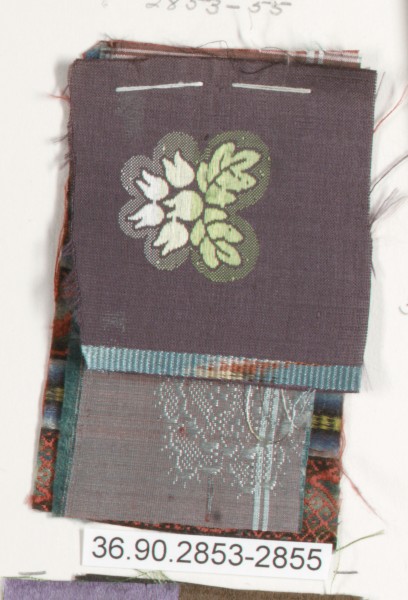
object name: piece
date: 1801-1900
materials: silk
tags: leaves